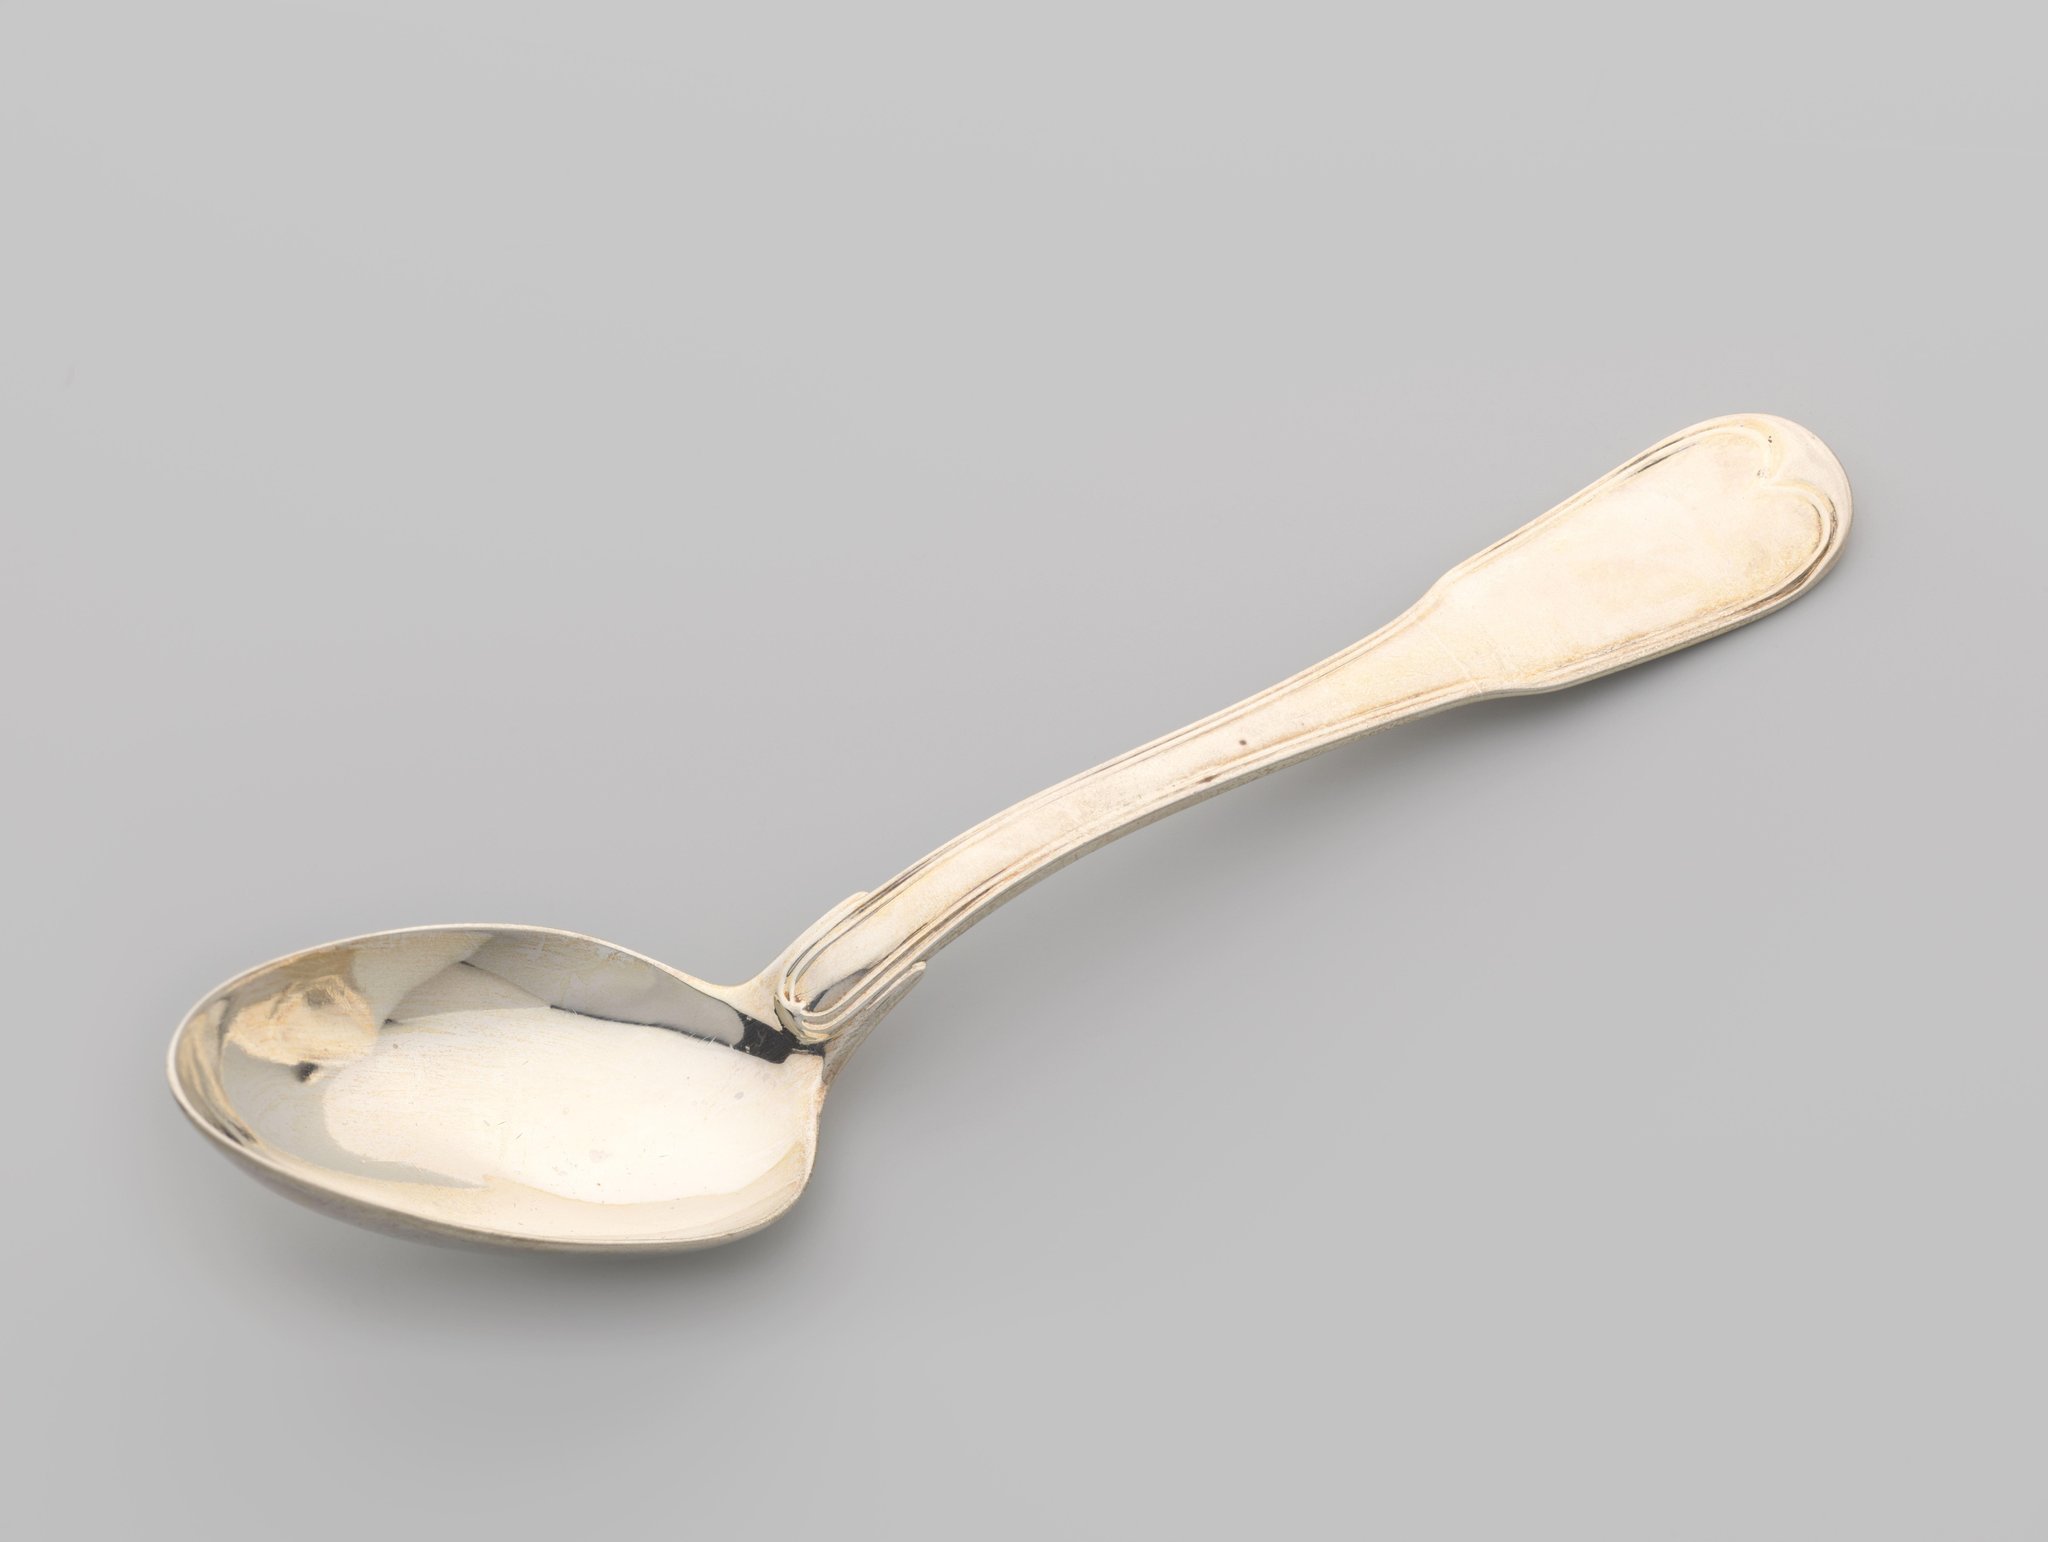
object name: groentelepel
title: Groentelepel met het familiewapen Clifford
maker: roelof helweg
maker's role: silversmith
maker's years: 1758-1843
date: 1800-1810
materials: silver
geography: amsterdam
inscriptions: alloy mark, date letter, town mark, maker's mark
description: De eivormige bak heeft een versmald uiteinde en is aan zowel boven- als onderzijde door middel van enkel lof verbonden met de platte, gebogen steel, die zich verbreedt naar het spatelvormige uiteinde. Boven- en onderzijde van de steel worden omgeven door een dubbele filetrand, die bij het uiteinde ingezewenkt is. Op de onderzijde van de spatel is het wapen Clifford gegraveerd.